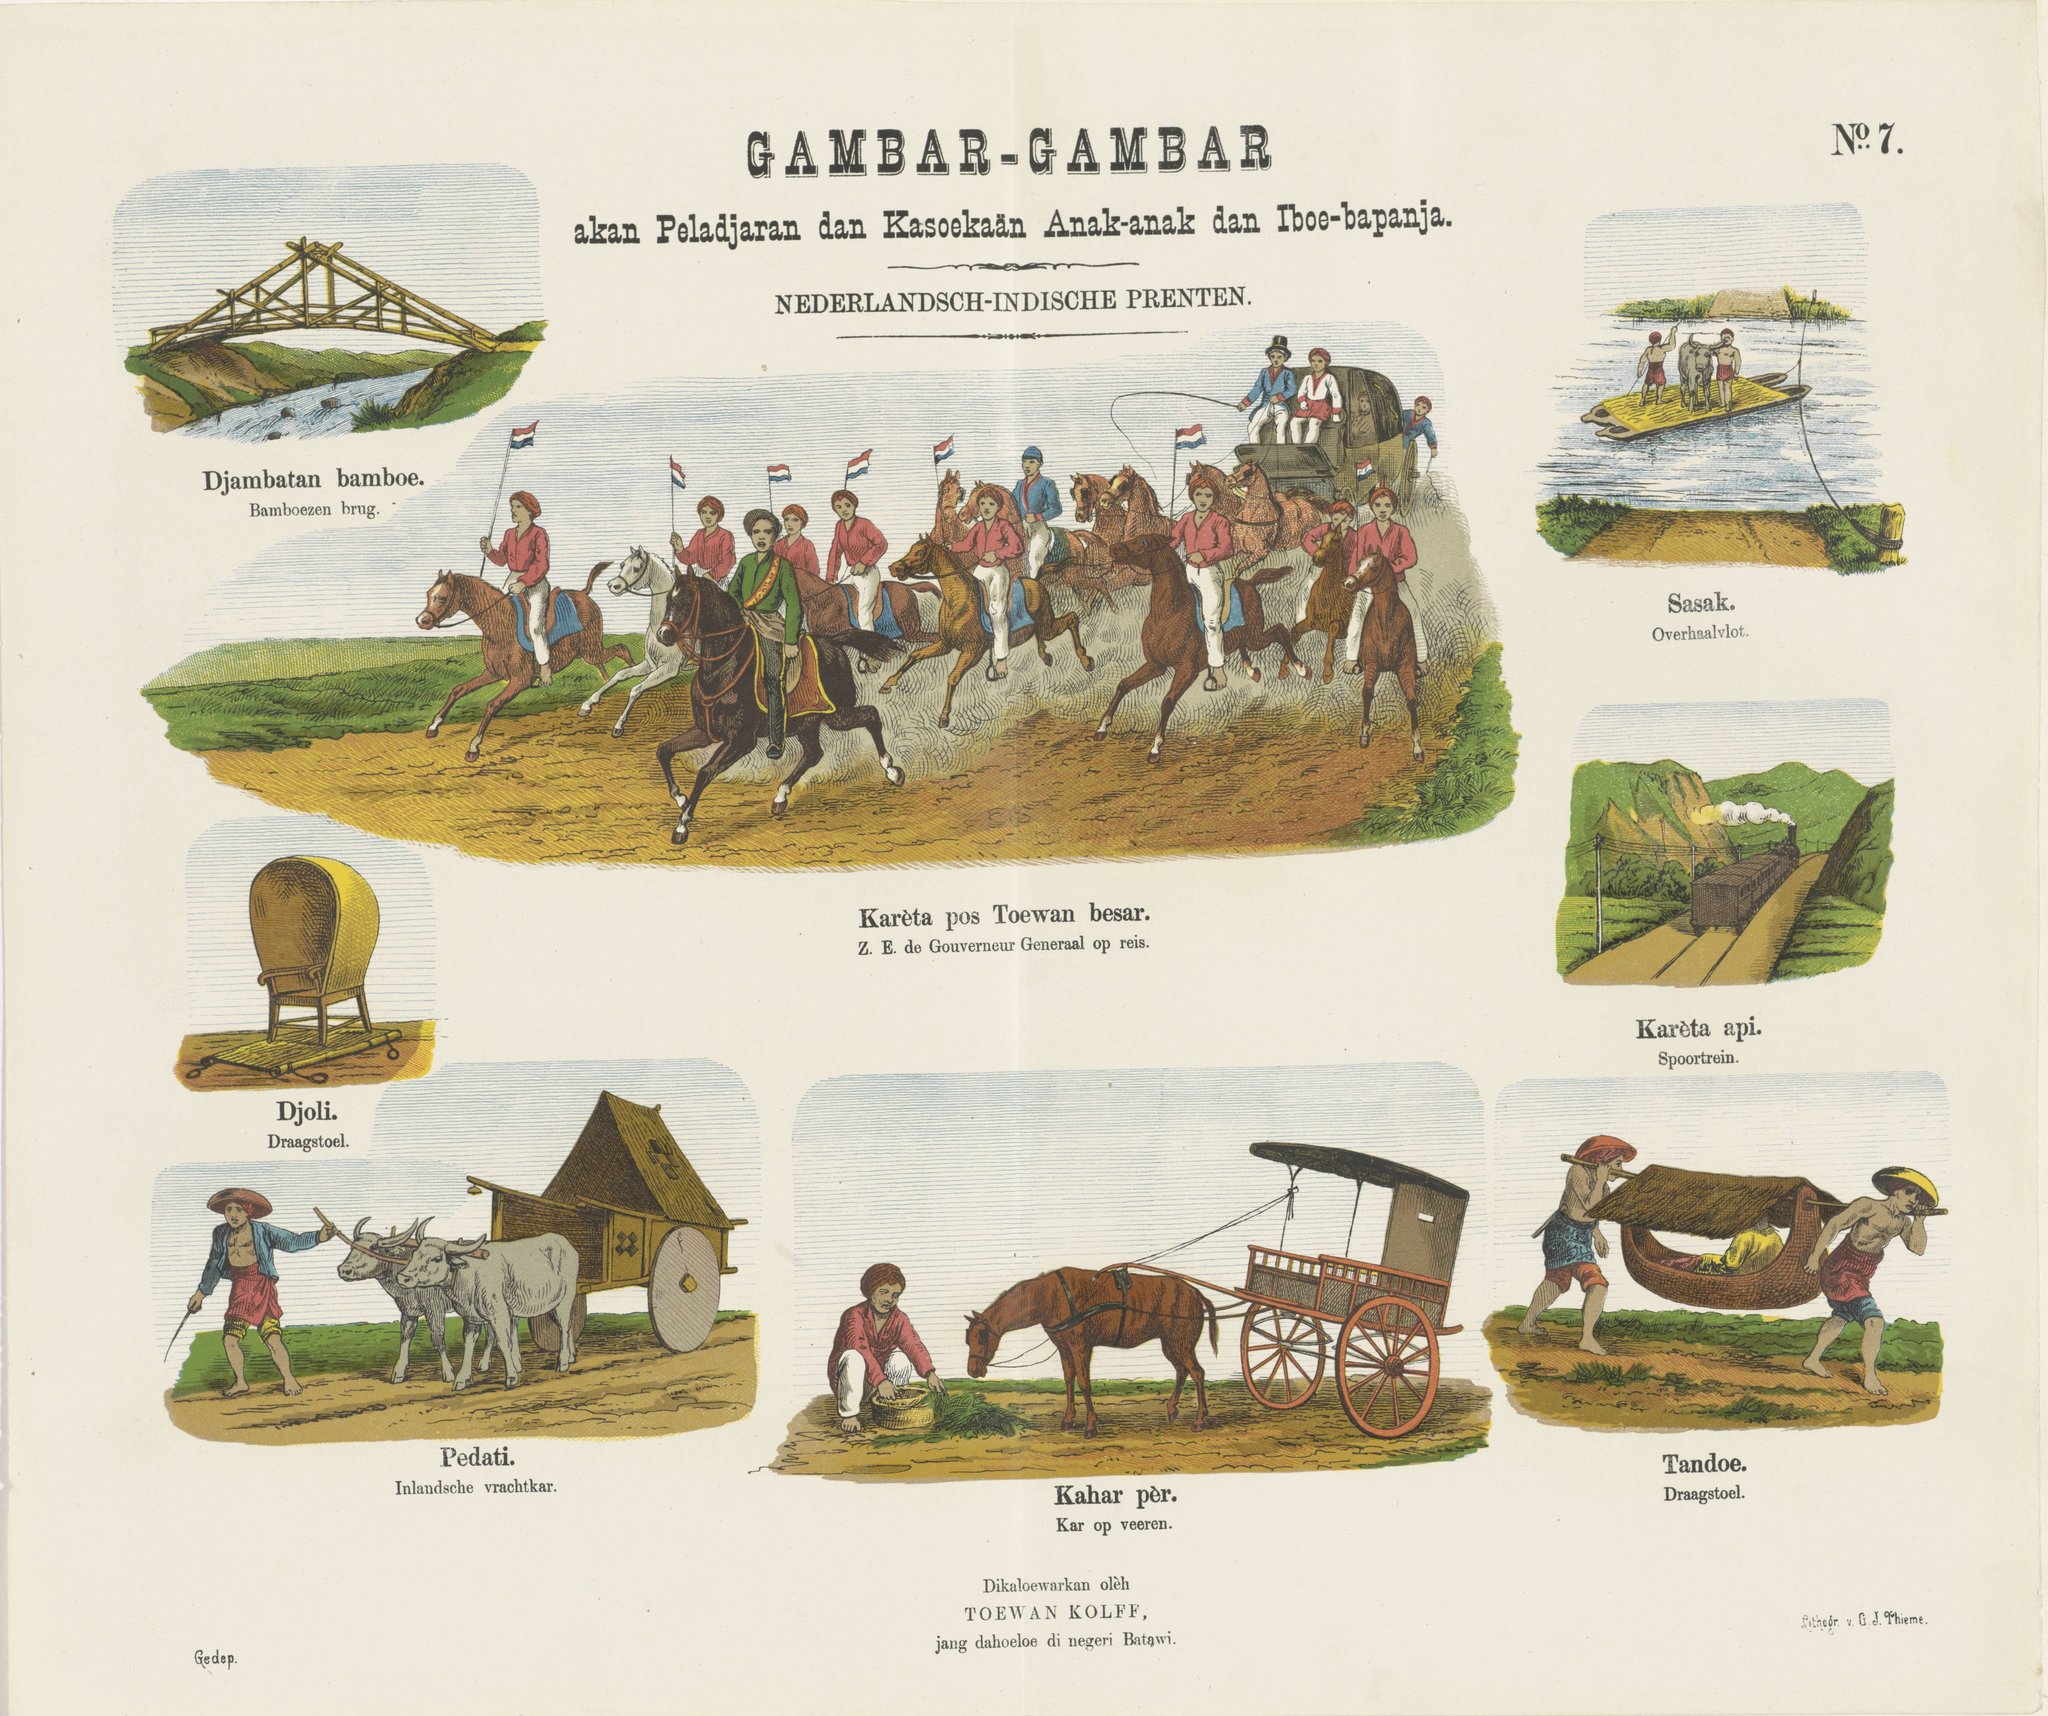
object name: print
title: Prenten tot nut en genoegen van jong en oud / Nederlandsch-Indische prenten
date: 1868-1881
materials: paper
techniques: lithograph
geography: netherlands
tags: asiatic races and peoples, colonial governor, four-wheeled, animal-drawn vehicle, e.g.: cab, carriage, coach, (carrying a person in a) sedan-chair, dutch east indies, the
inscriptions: collector's mark: Lugt 2760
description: Blad met acht voorstellingen van de gouverneur-generaal op reis en verschillende vervoersmiddelen en infrastructuur in de voormalige kolonie Nederlands-Indië, waaronder een draagstoel, een kar op veren, een overhaalvlot en een brug. Onder elke afbeelding een onderschrift in het Maleis en het Nederlands. Genummerd rechtsboven: No. 7.